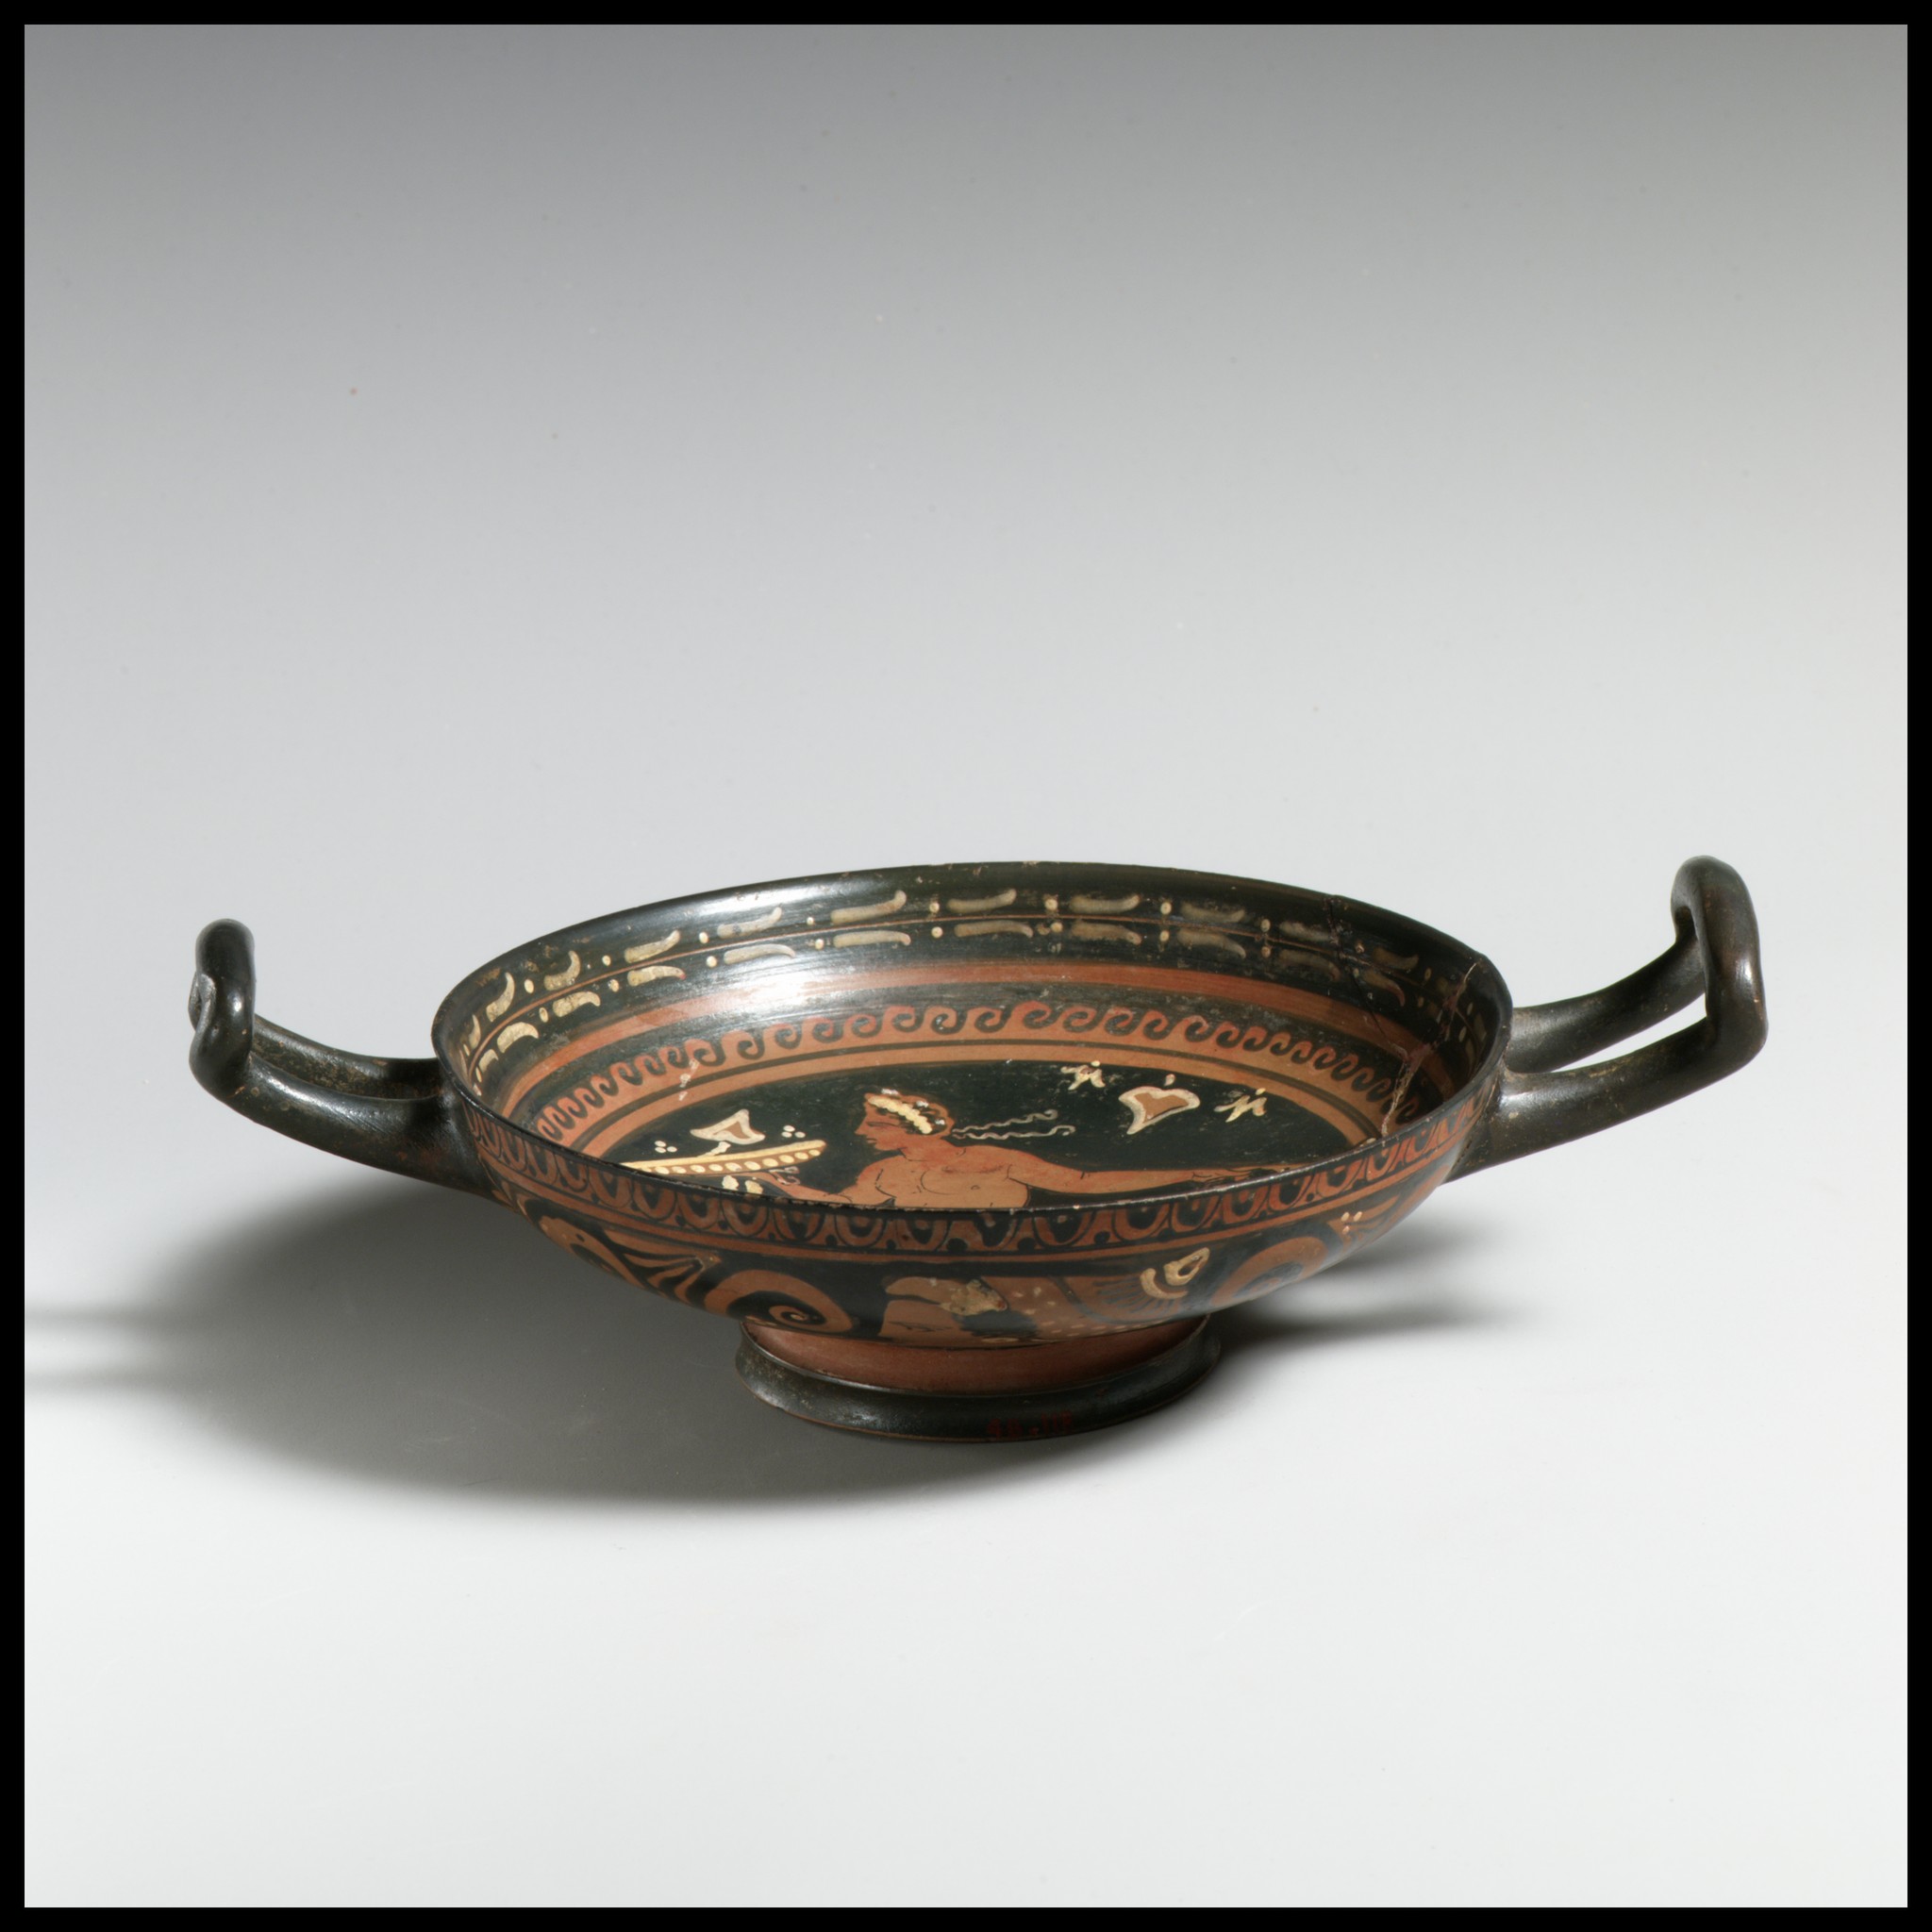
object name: kylix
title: Terracotta stemless kylix (drinking cup)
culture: greek, south italian, apulian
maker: amphorae painter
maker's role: artist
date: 340-320 BCE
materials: terracotta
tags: heads,male nudes,women,wreaths